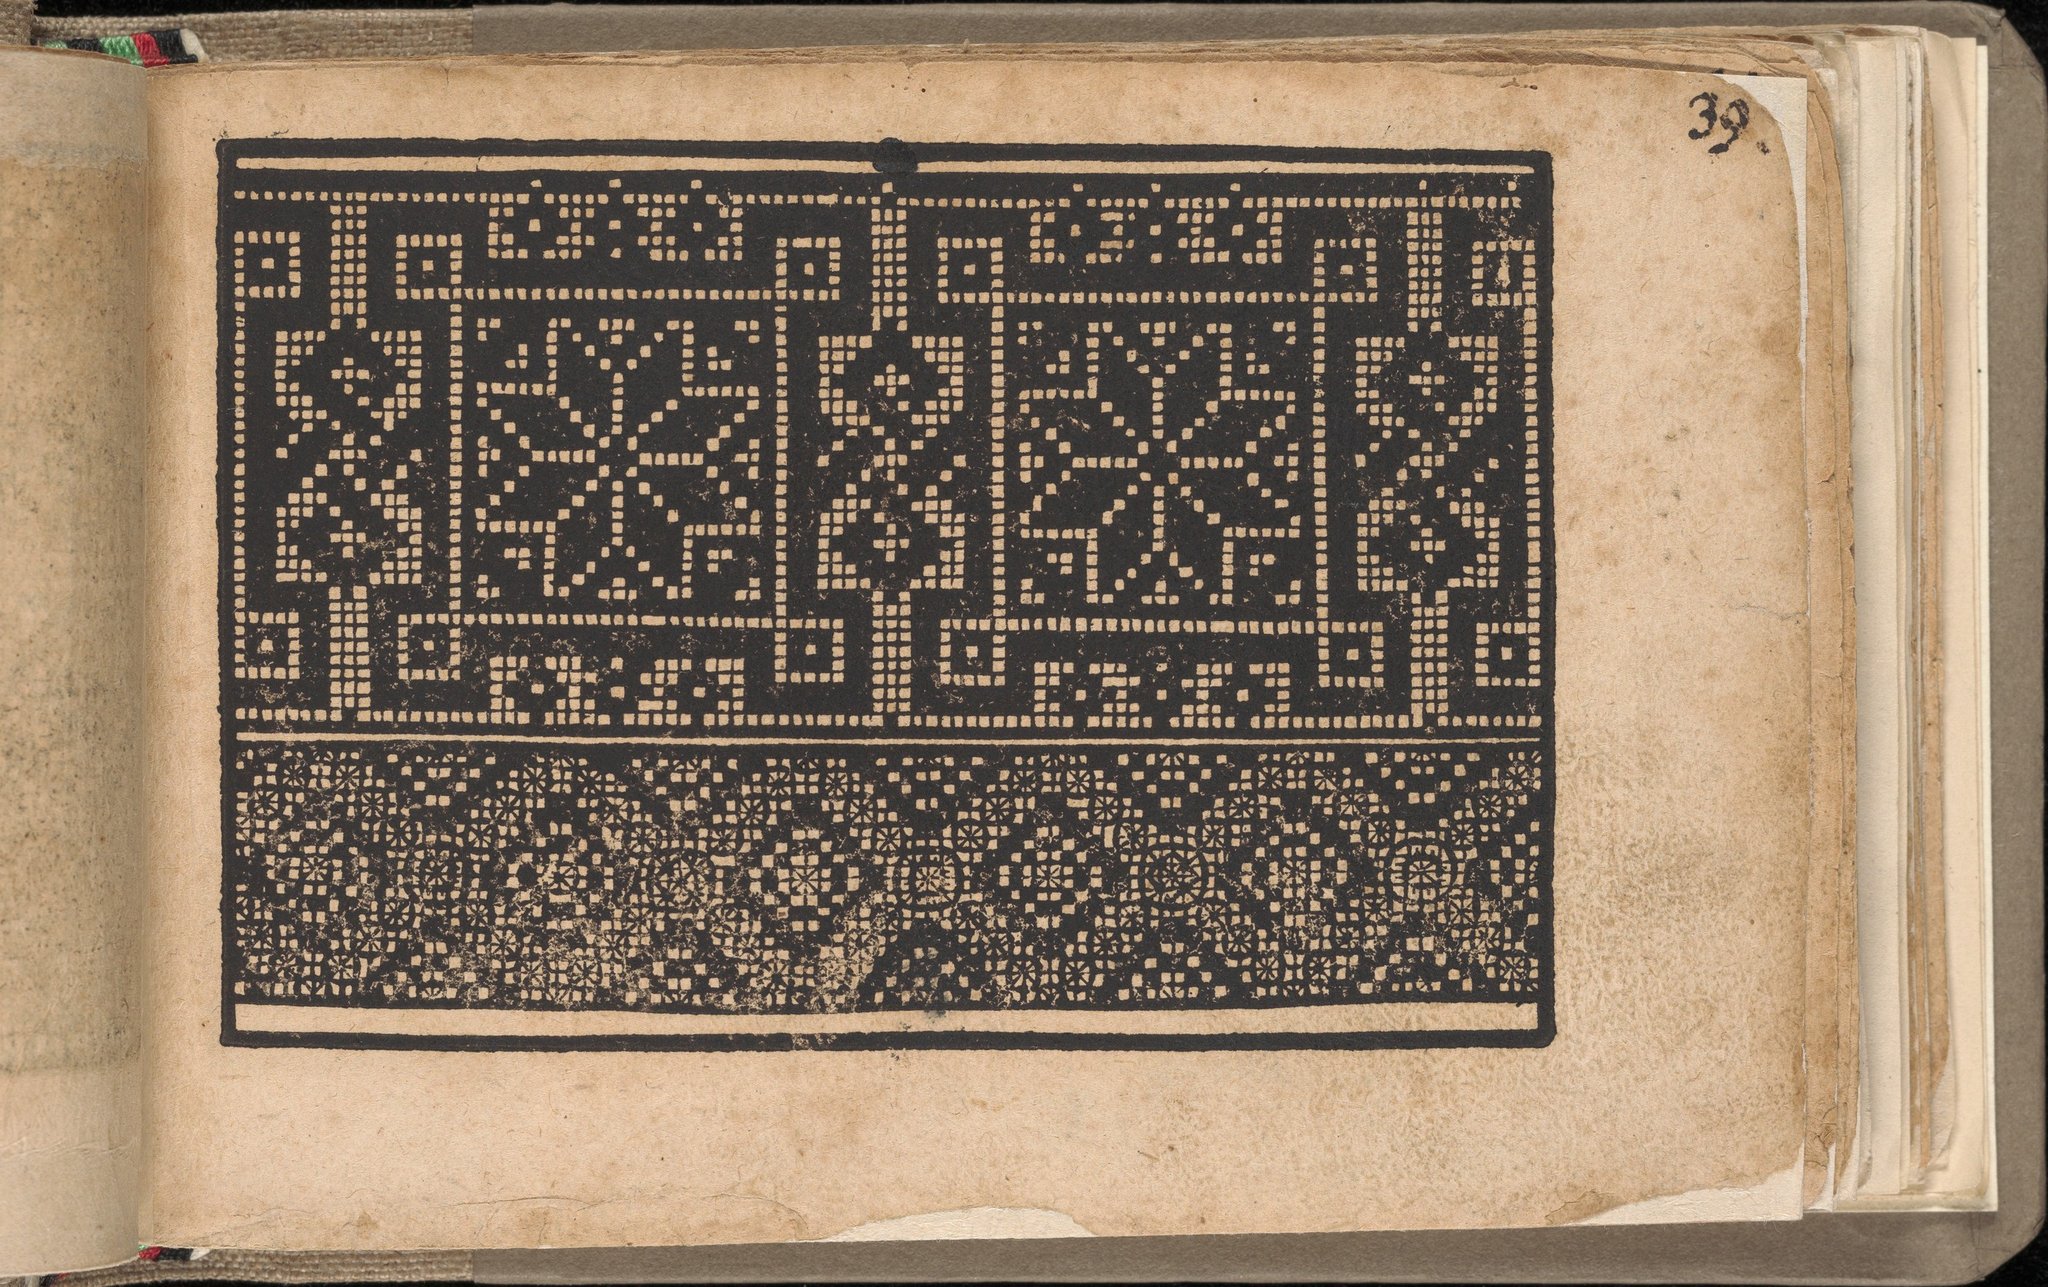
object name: book print ornament architecture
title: Schön newes Modelbuch (Page 39r)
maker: sigismundus latomus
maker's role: publisher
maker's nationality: german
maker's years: 1599-1632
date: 1608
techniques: woodcut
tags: ornament